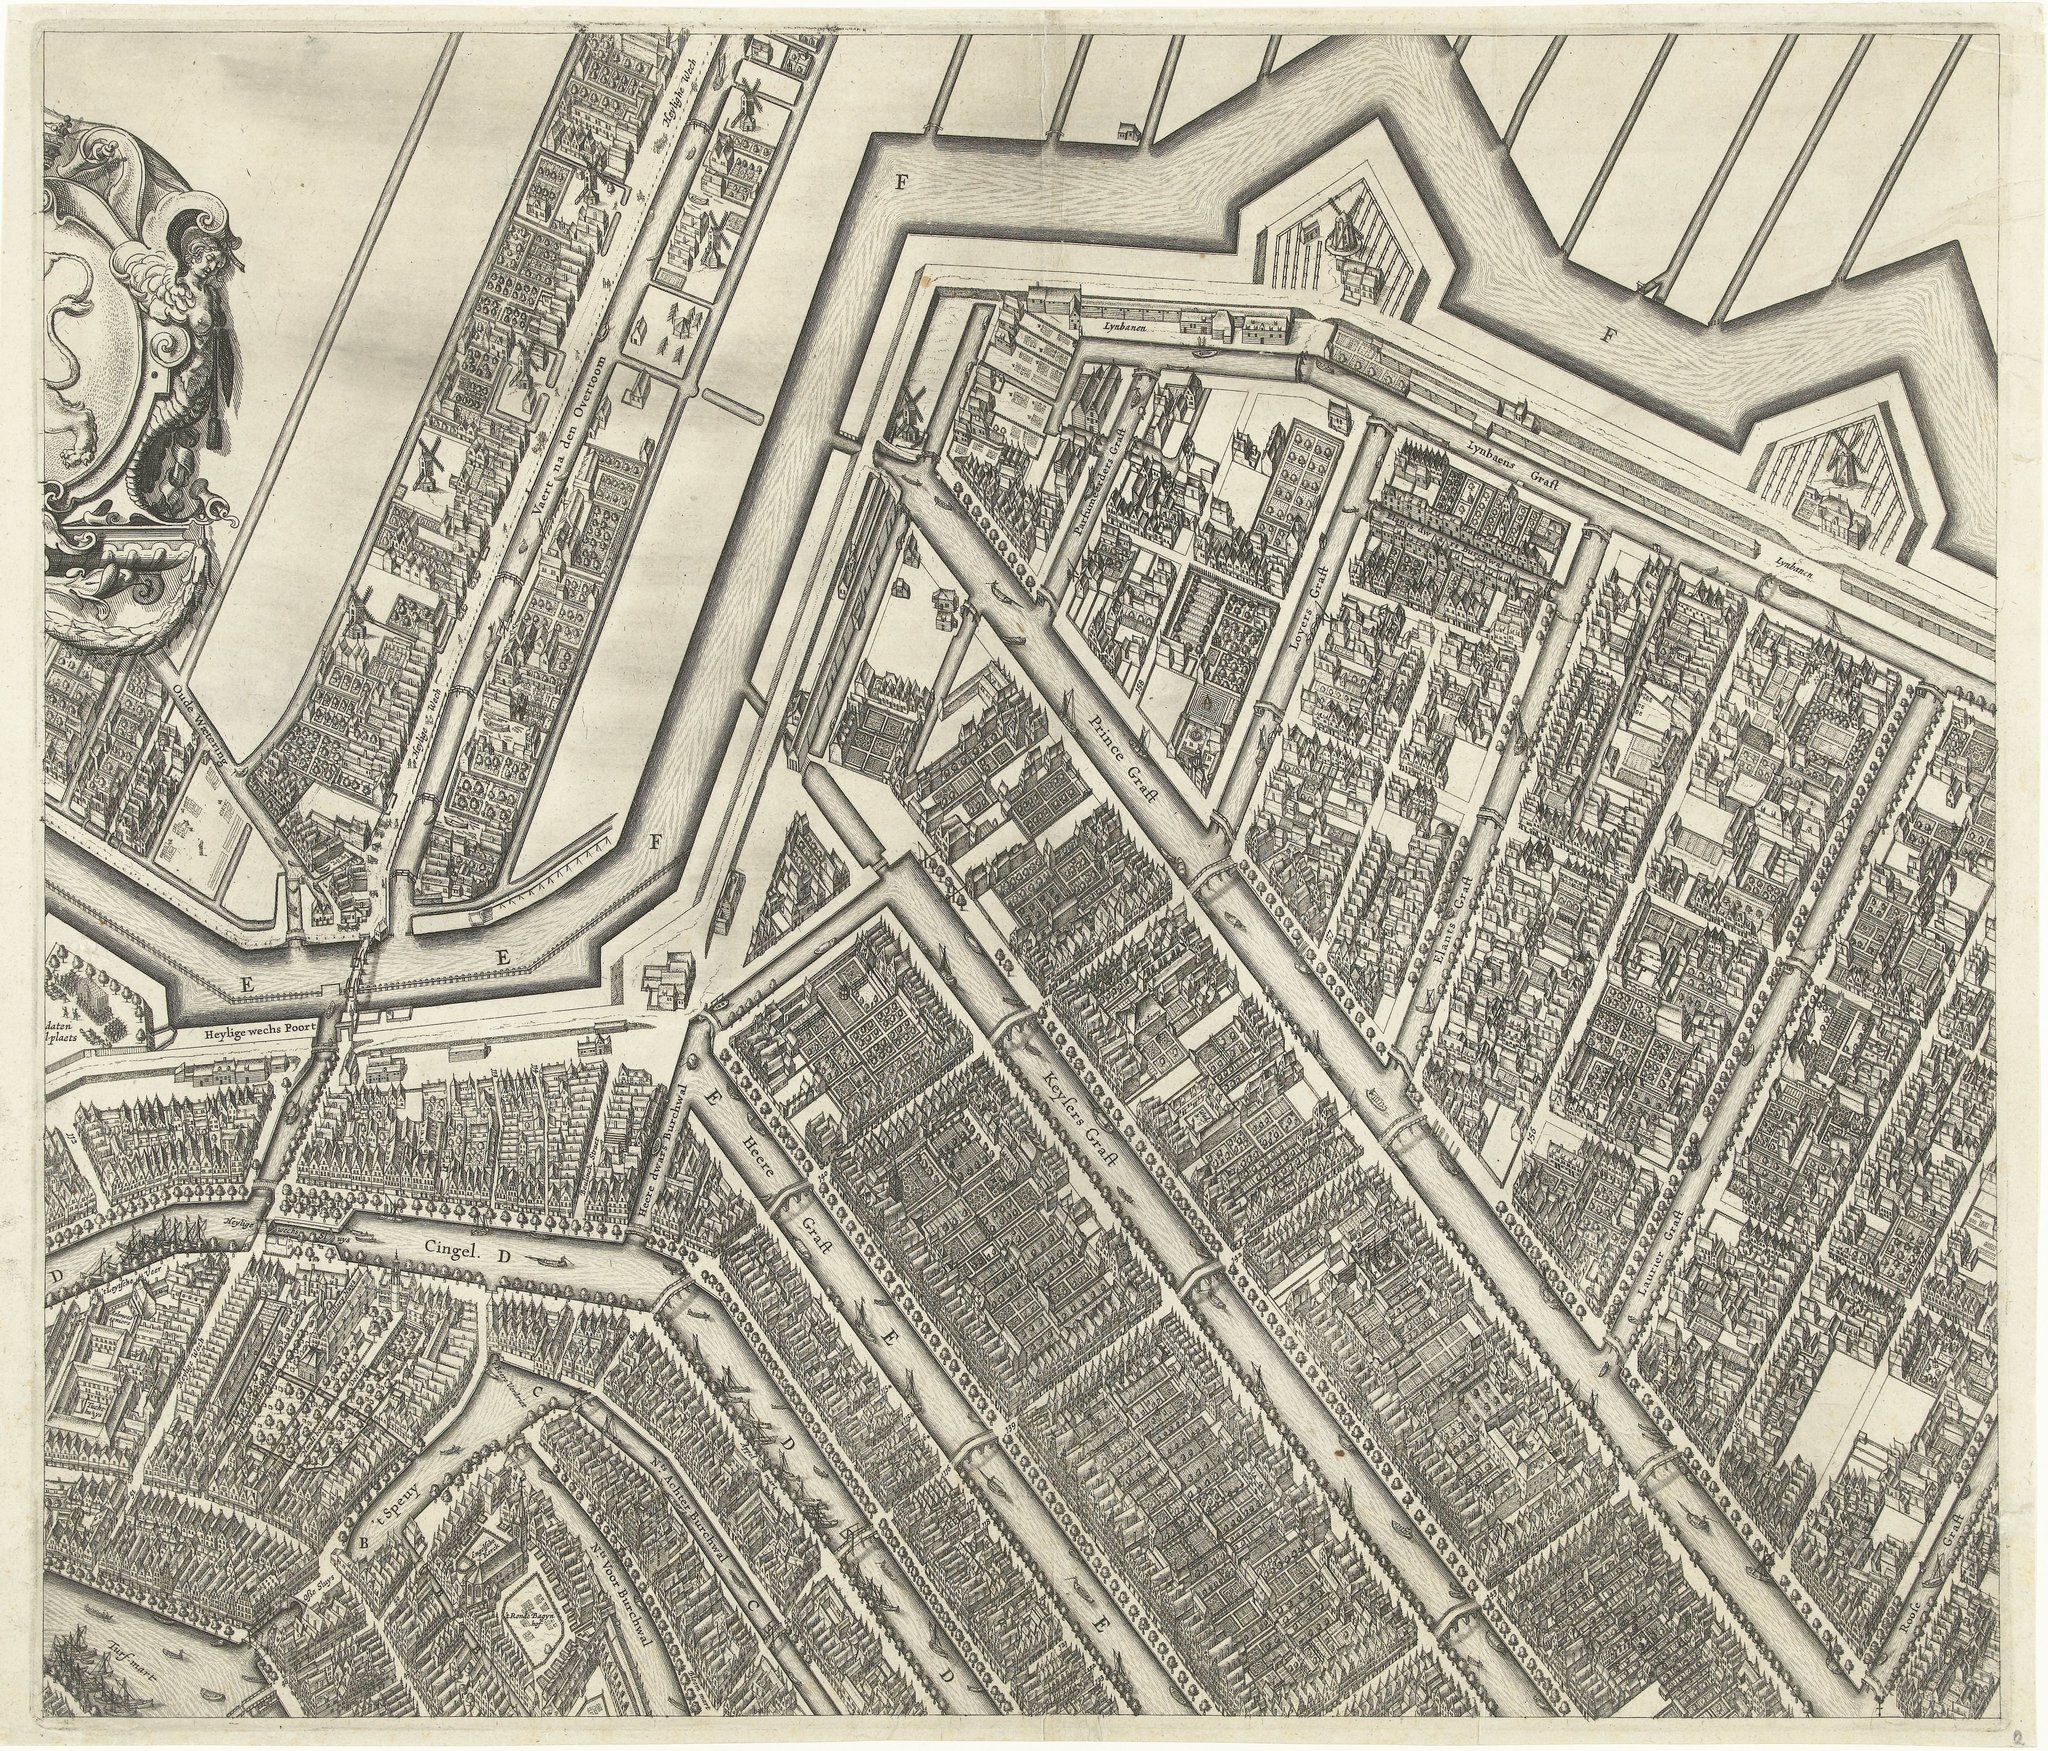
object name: print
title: Plattegrond van Amsterdam (blad middenboven)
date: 1625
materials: paper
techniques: etching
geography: northern netherlands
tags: maps of cities, amsterdam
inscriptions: collector's mark: Lugt 2228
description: Grote plattegrond van de stad Amsterdam uit 1625. Linksboven een gezicht op de stad en rechtsboven een kaart van de omgeving. Rechts een lijst met de namen van straten aan de Oude en de Nieuwe stadszijde. De plattegrond is samengesteld uit negen platen, waarvan twee ontbreken. Dit is het blad middenboven met het begin van de Overtoom en het Begijnenhof.